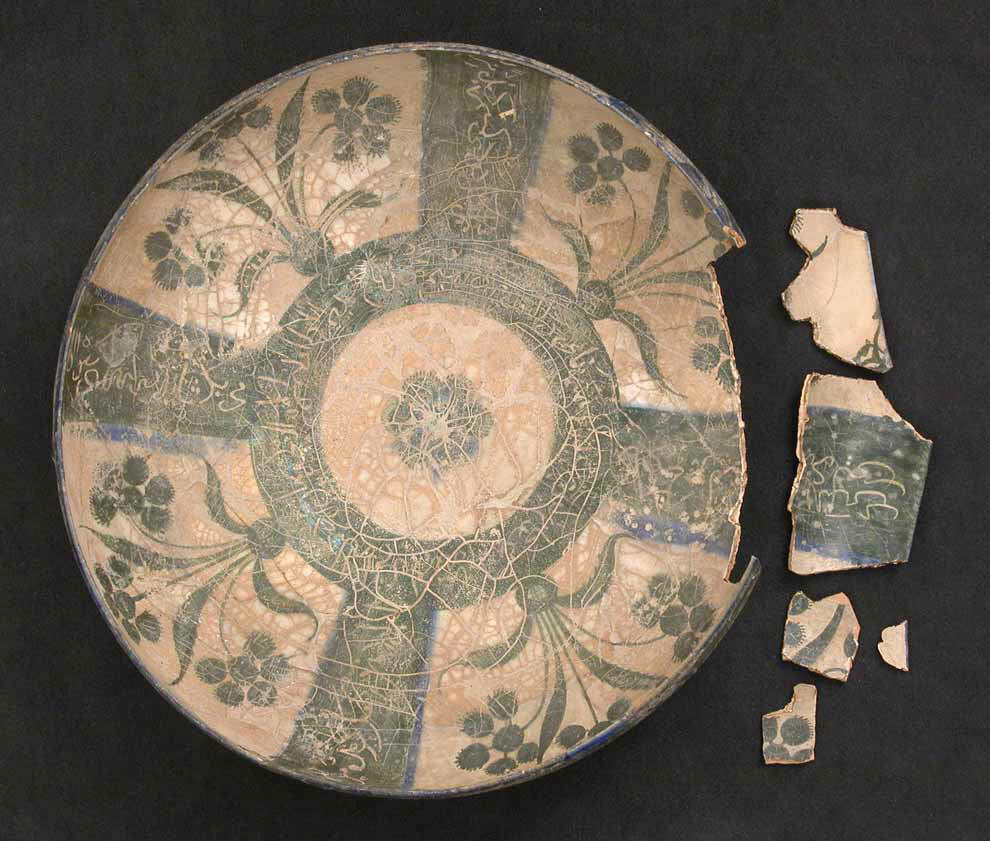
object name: bowl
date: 1201-1300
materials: earthenware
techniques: painting, underglaze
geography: iran